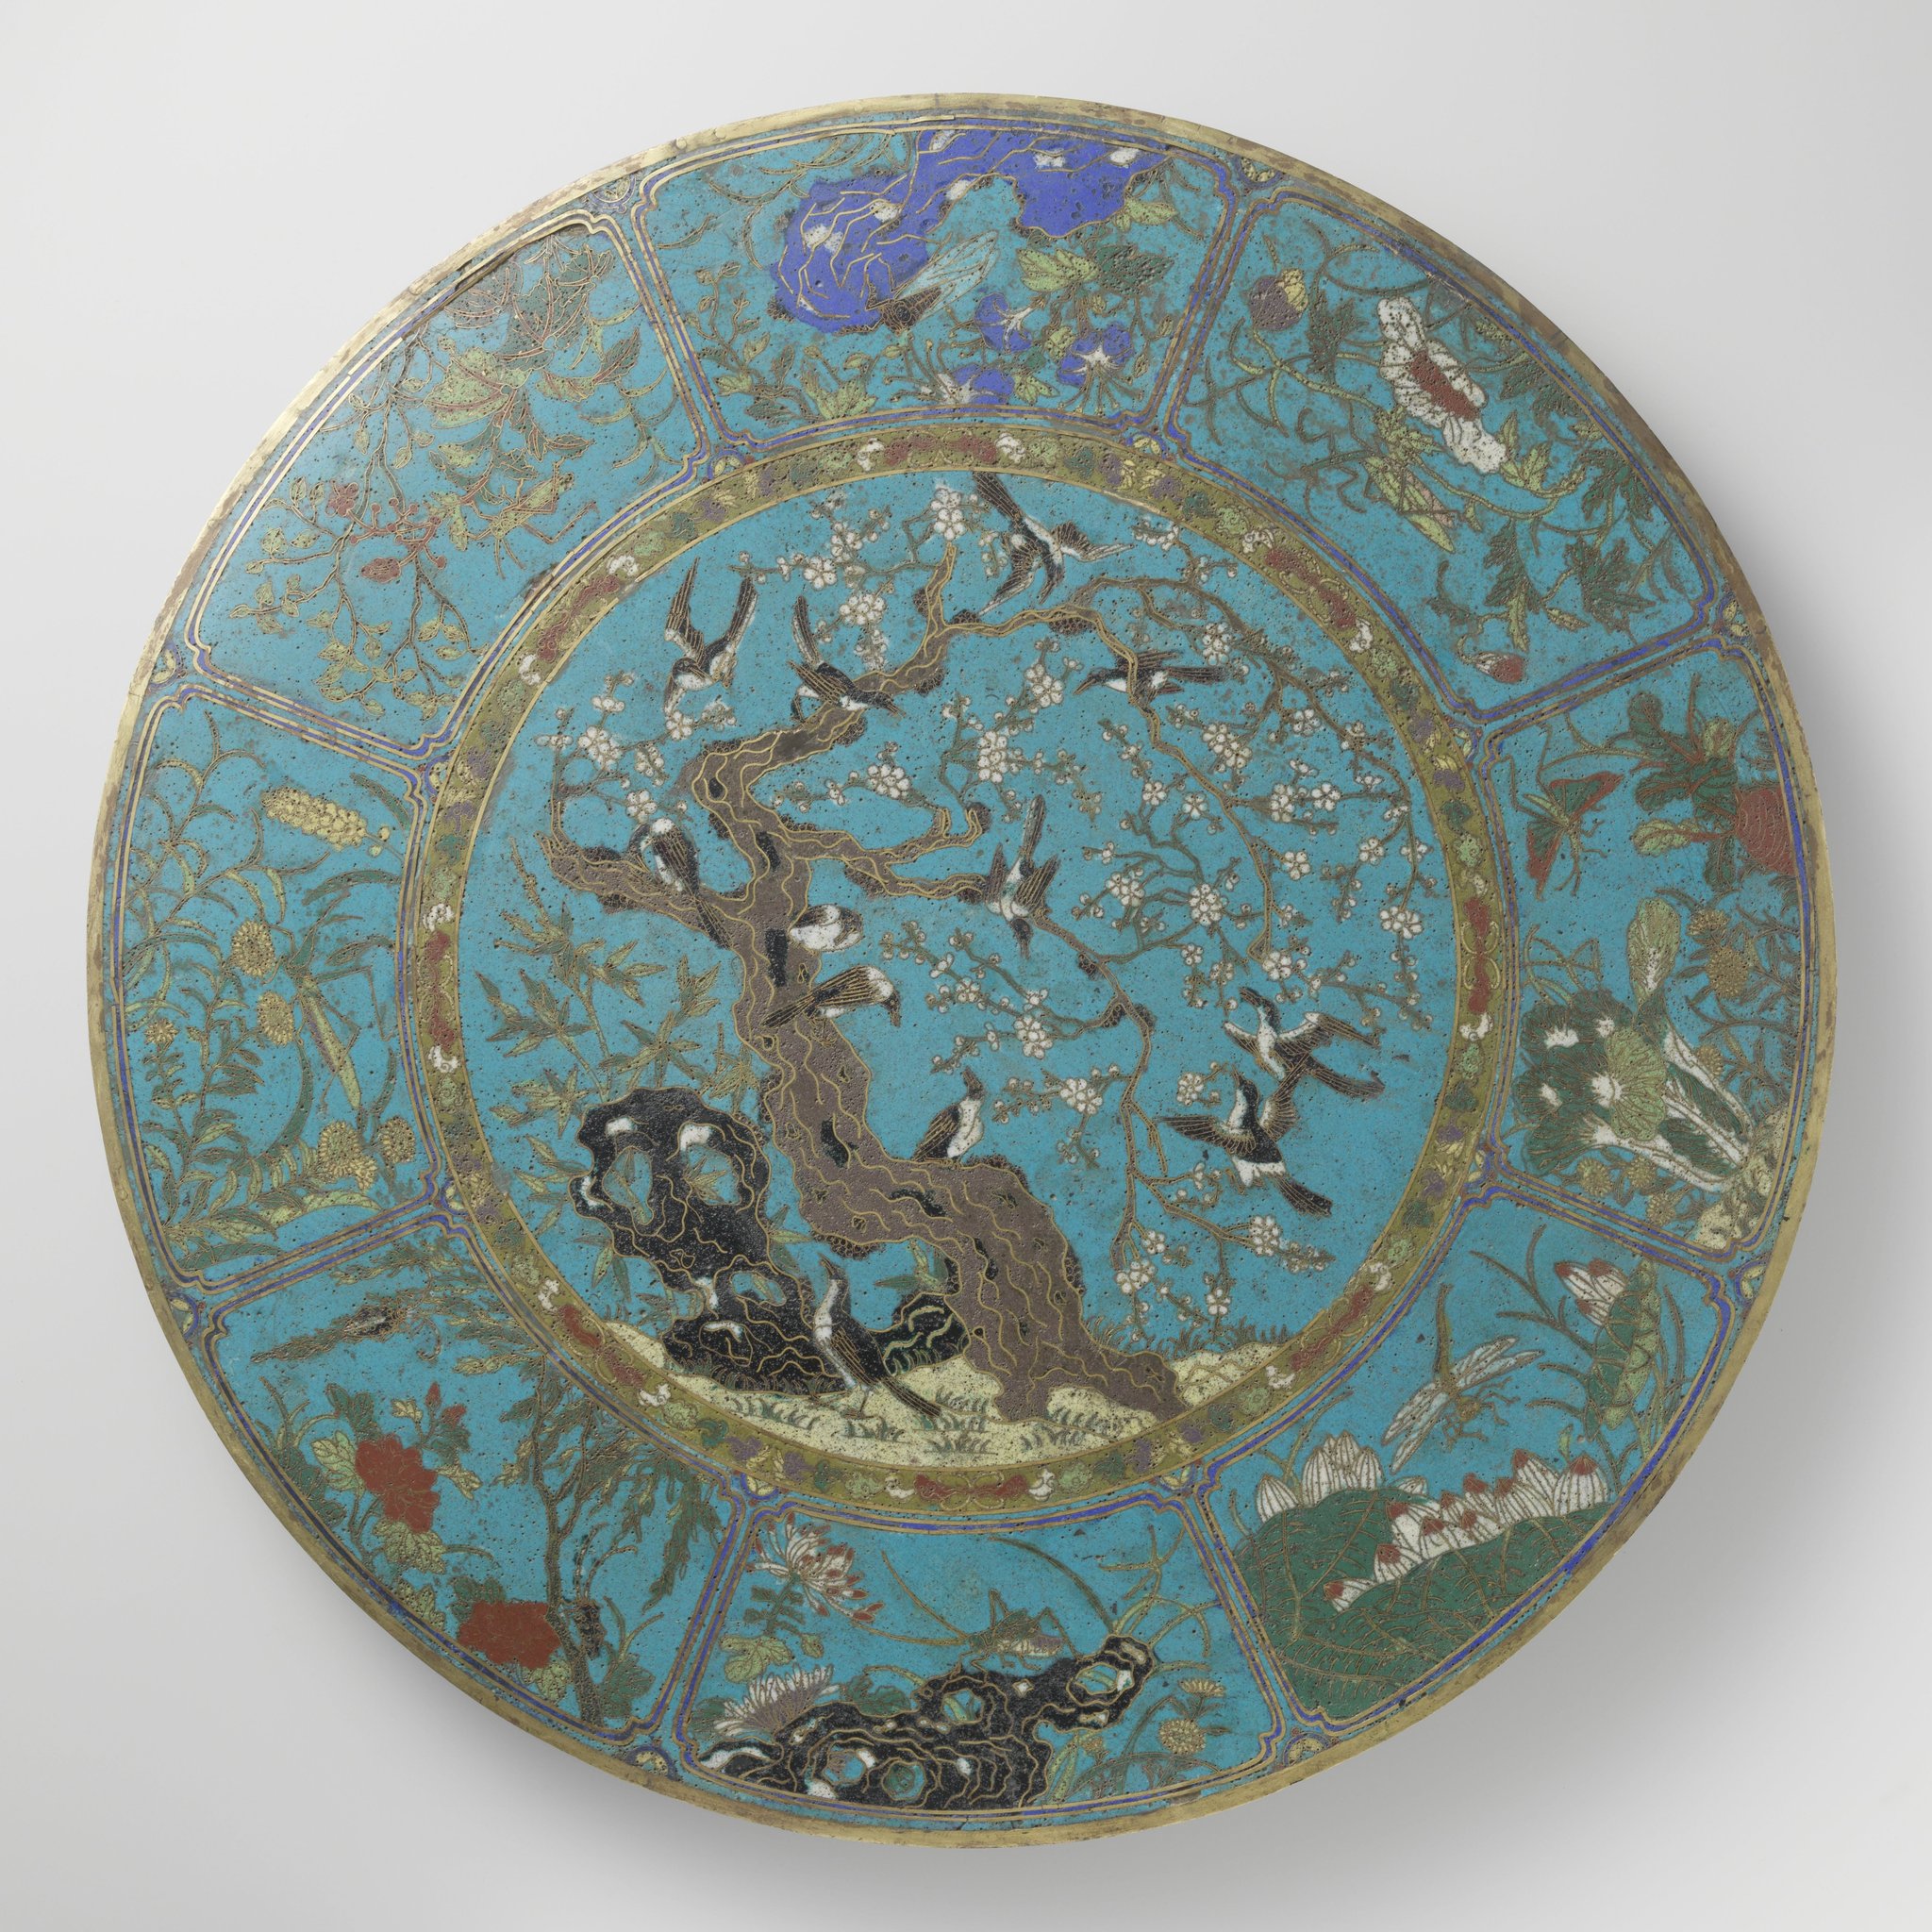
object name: plaque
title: Pair of plaques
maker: Anonymous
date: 1600-1699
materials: copper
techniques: enamel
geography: china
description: These plaques, possibly used as table tops, are covered with auspicious symbols: the butterfly represents a long life, and the magpie joy, while the blossoming plum tree and bamboo signify life force. The cloisonné enamel technique flourished in China from the Ming dynasty (1368–1644) onwards. Copper wire soldered onto the copper ground created the outlines of the design; these spaces were then filled with coloured glass paste, which melted and flowed when heated.